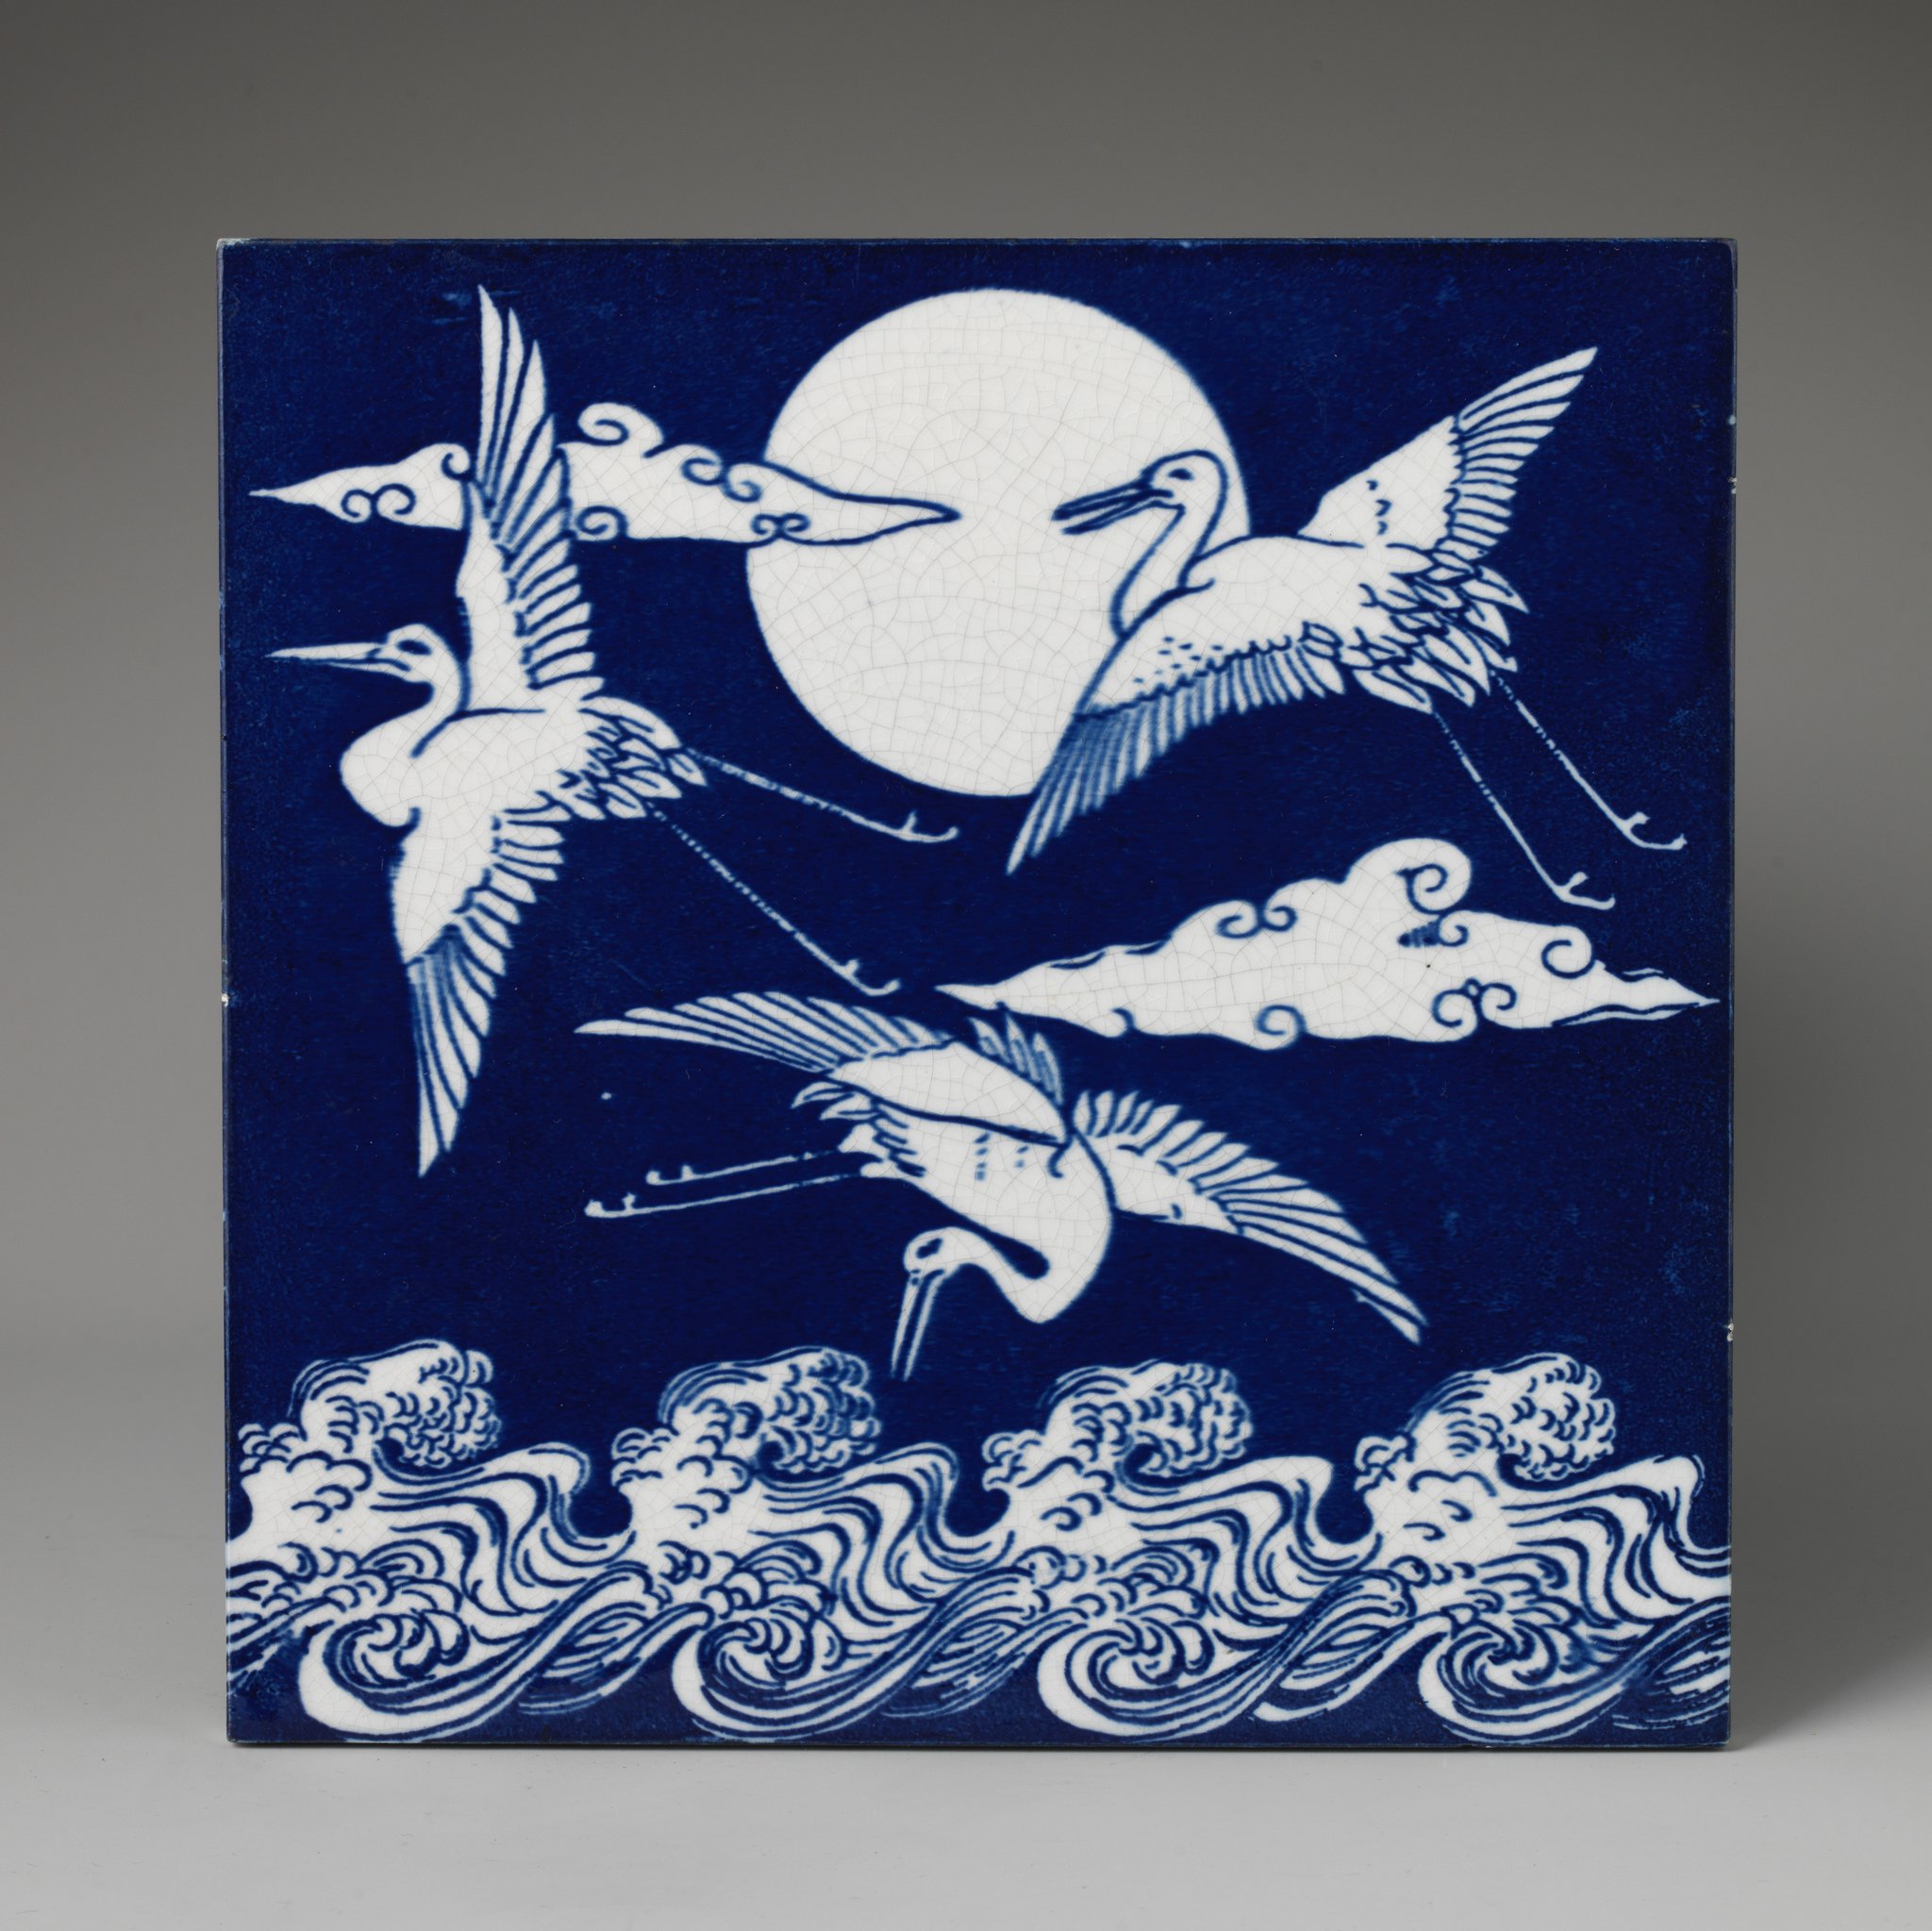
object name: tile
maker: minton(s)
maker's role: factory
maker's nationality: british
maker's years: 1793-2001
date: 1875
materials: earthenware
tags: cranes,moon